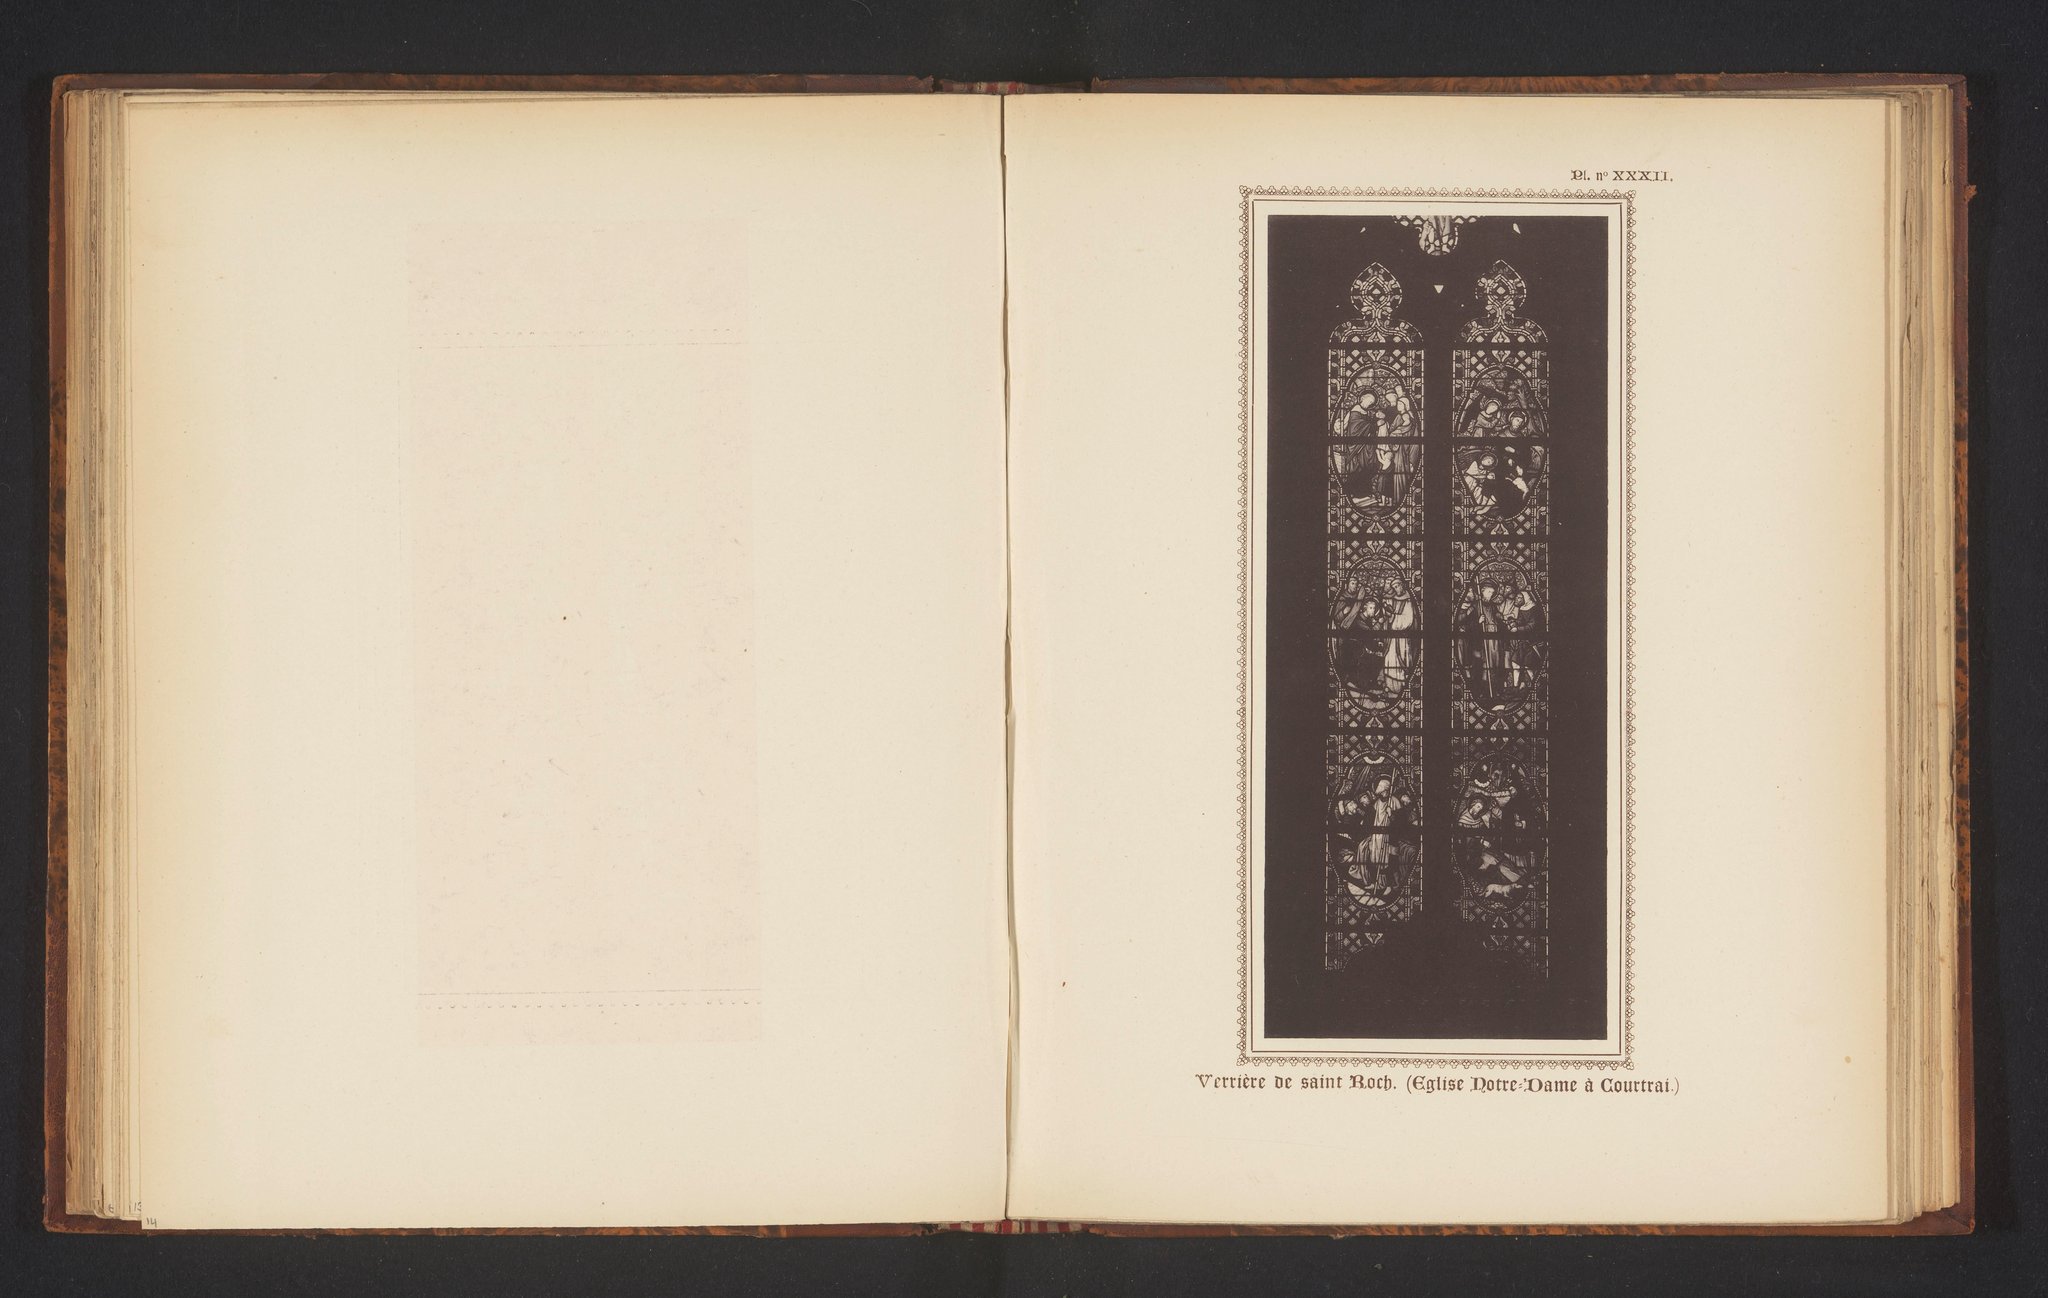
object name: page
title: Gebrandschilderd raam in de Onze-Lieve-Vrouwekerk in Kortrijk, België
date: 1891-1896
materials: paper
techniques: photograph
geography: kortrijk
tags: church-window, e.g. rose-window, interior of church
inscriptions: number: ‘Pl. no XXXII.’